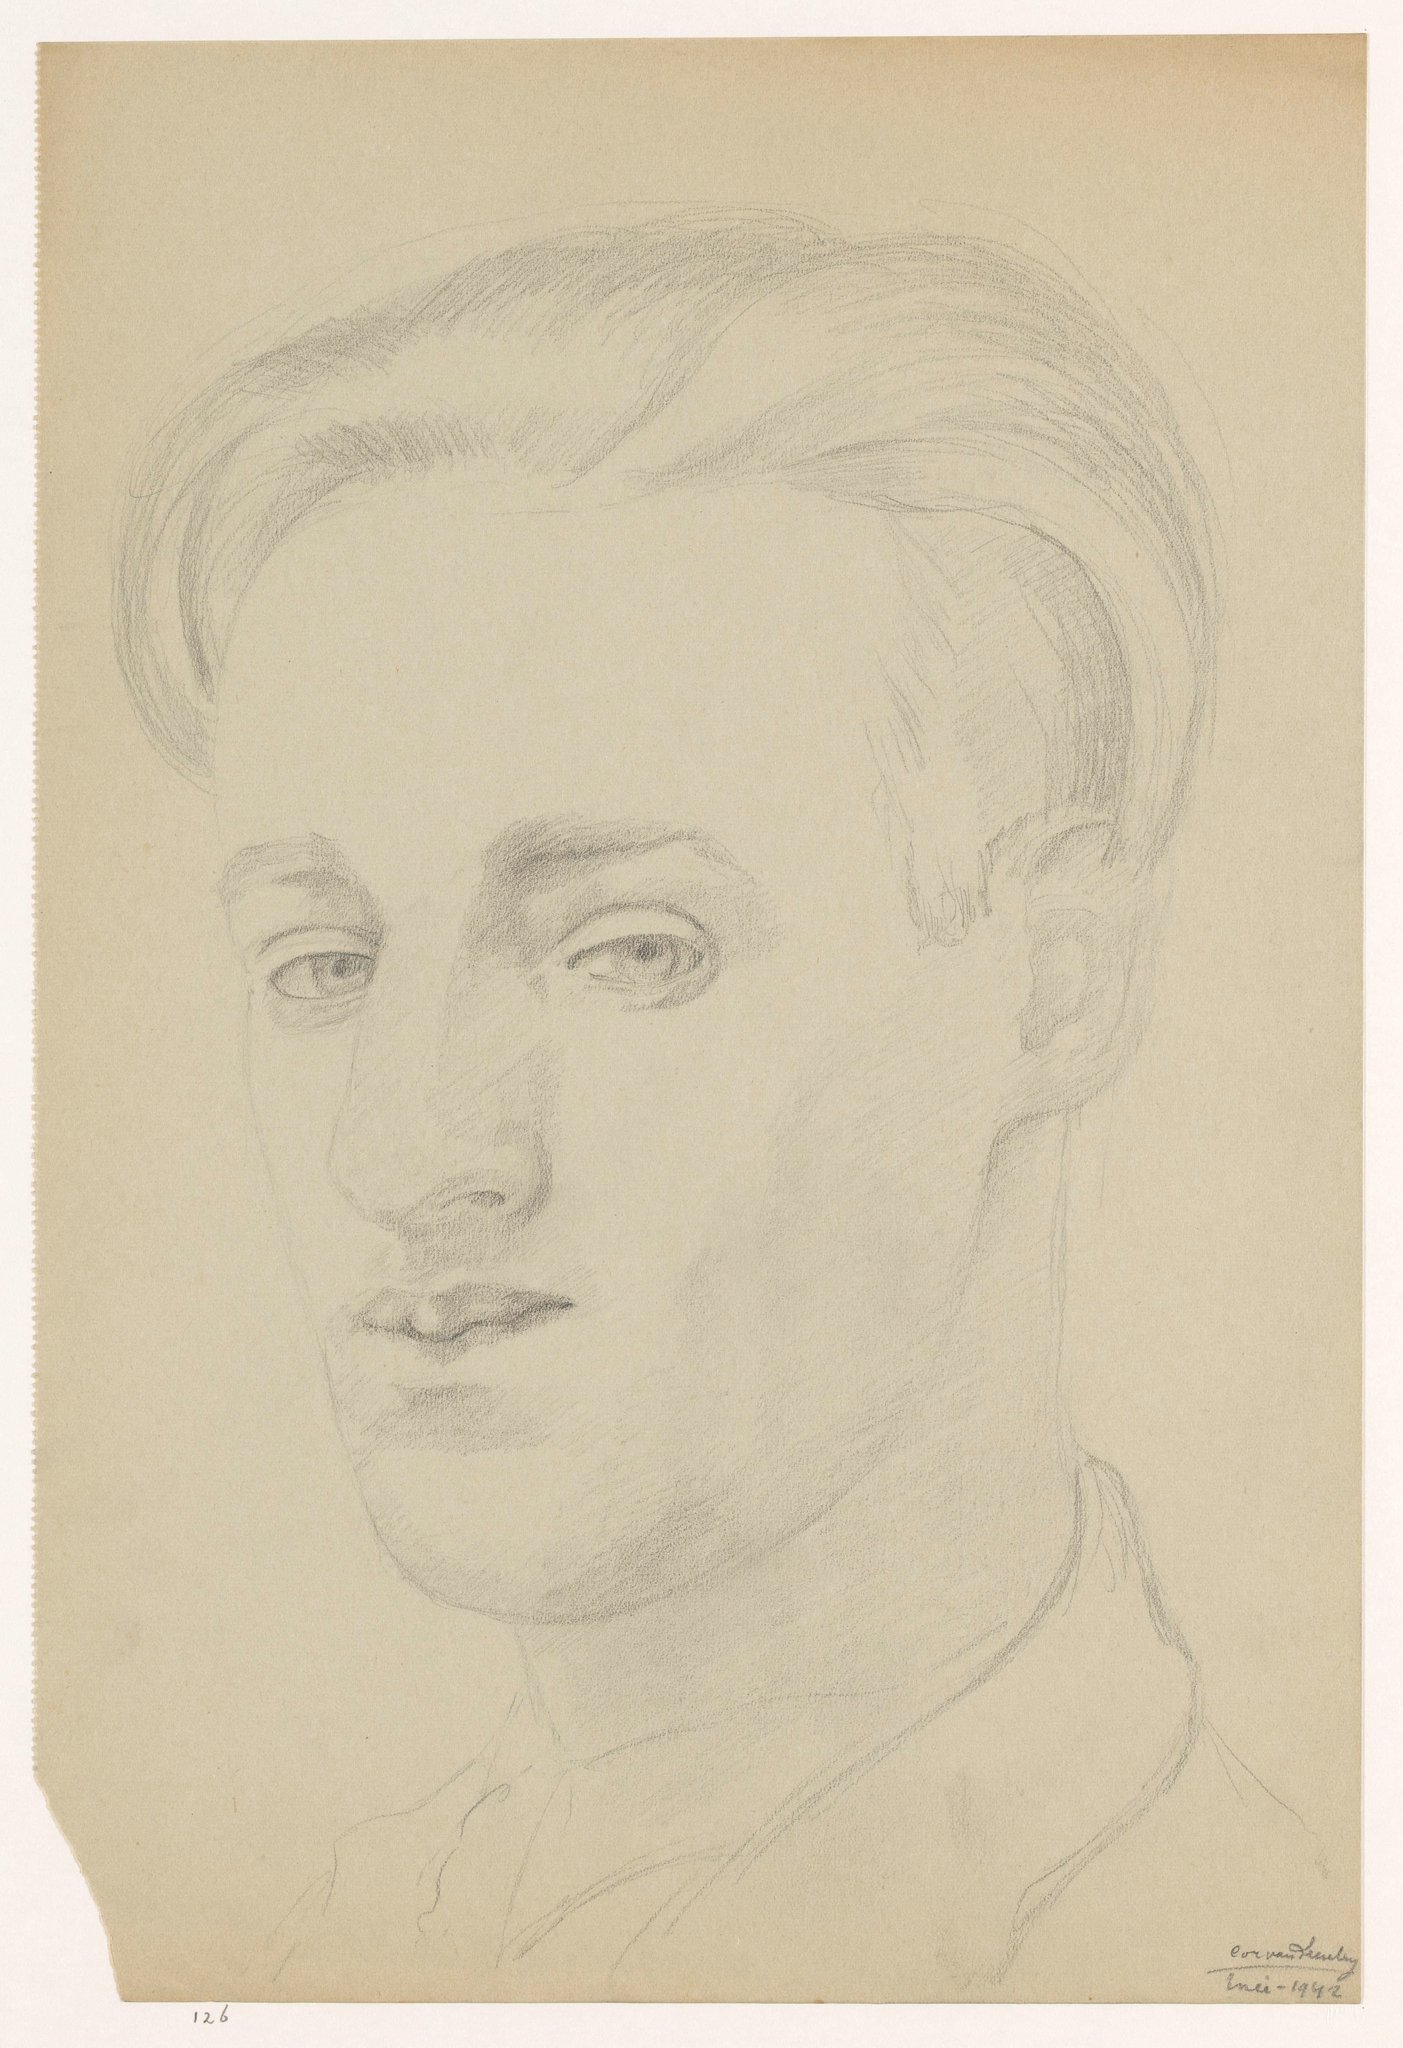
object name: drawing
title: Zelfportret, mei 1942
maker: cor van teeseling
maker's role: draughtsman, sculptor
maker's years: 1915-1942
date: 1905-1942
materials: paper, pencil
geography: amsterdam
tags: amsterdam, draughtsman, sculptor, cor van teeseling, historical persons, prisoner in cell or locked place, portrait, self-portrait of draughtsman, netherlands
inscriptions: inscription: ‘Blijf trouw...... ha, ha, ha’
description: Zelfportret van Cor van Teeseling, mei 1942. Cor van Teeseling driekwart afgebeeld, zijn hoofd naar links gewend.